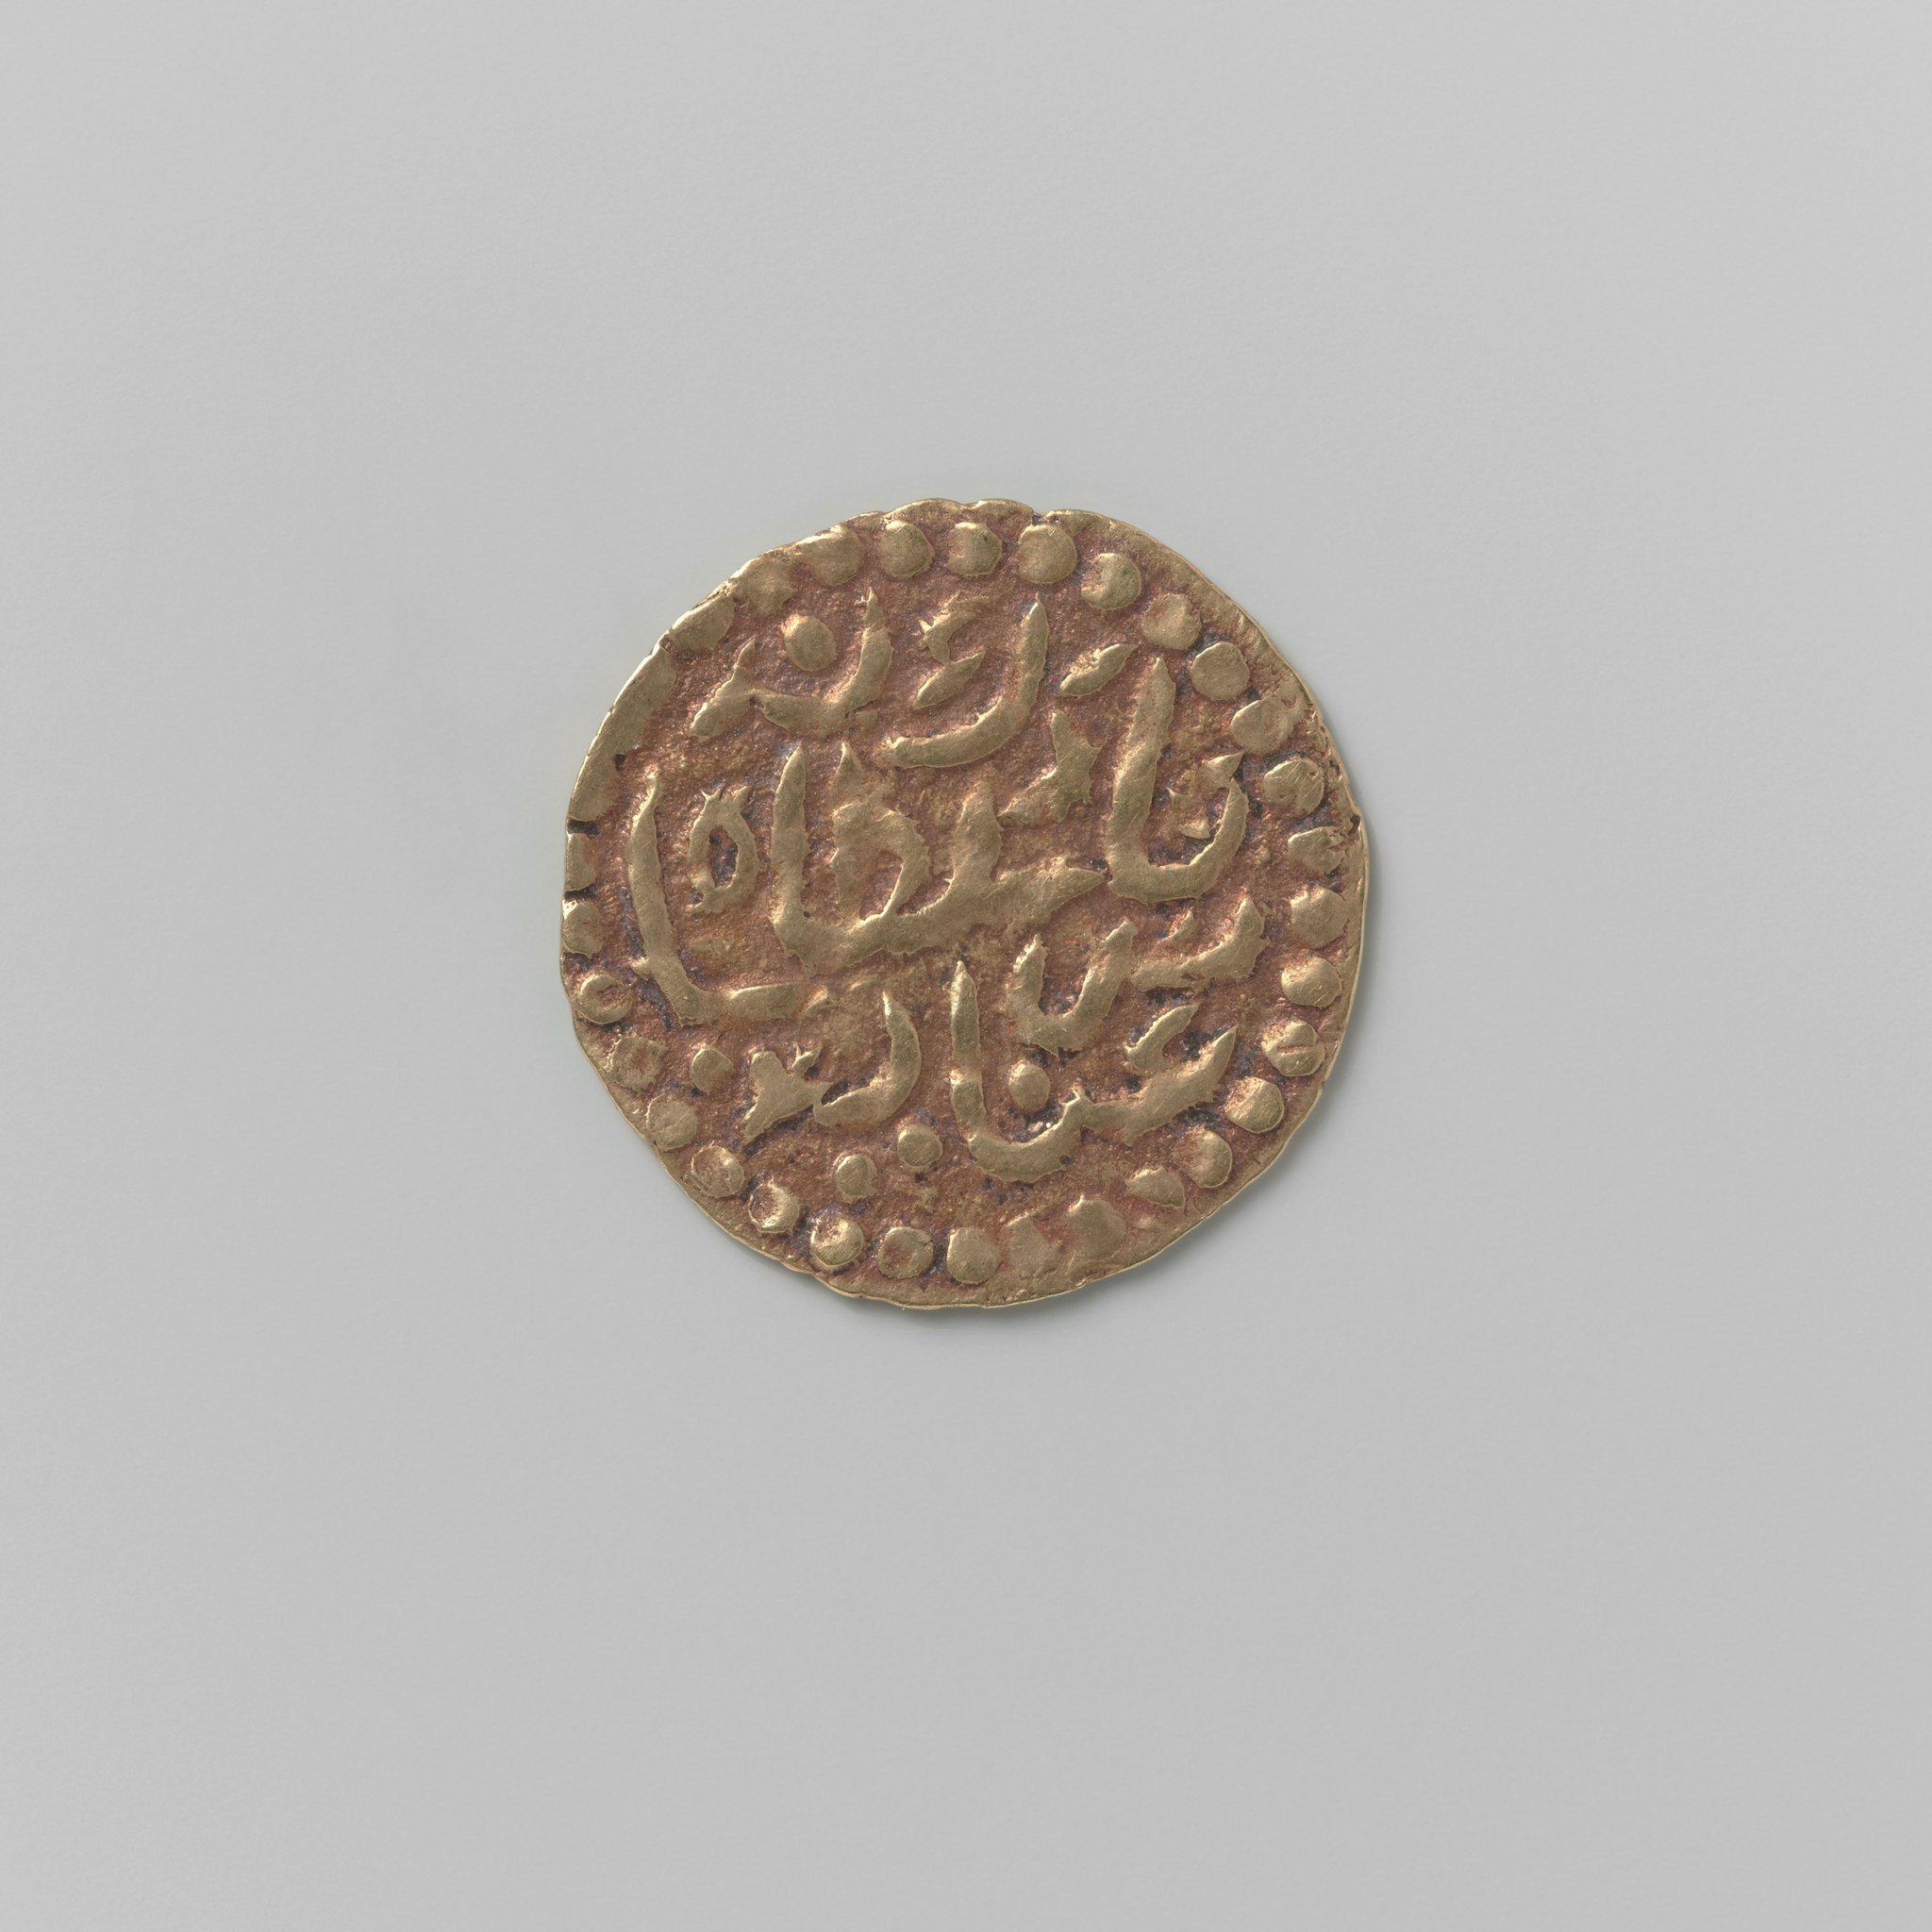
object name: coin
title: Mas van de sultanah Inayat Shah van Atjeh, Sumatra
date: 1678-1688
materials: gold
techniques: striking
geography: aceh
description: Gouden munt. Voorzijde: drieregelig opschrift in Arabische lettertekens. Keerzijde: drieregelig opschrift in Arabische lettertekens.